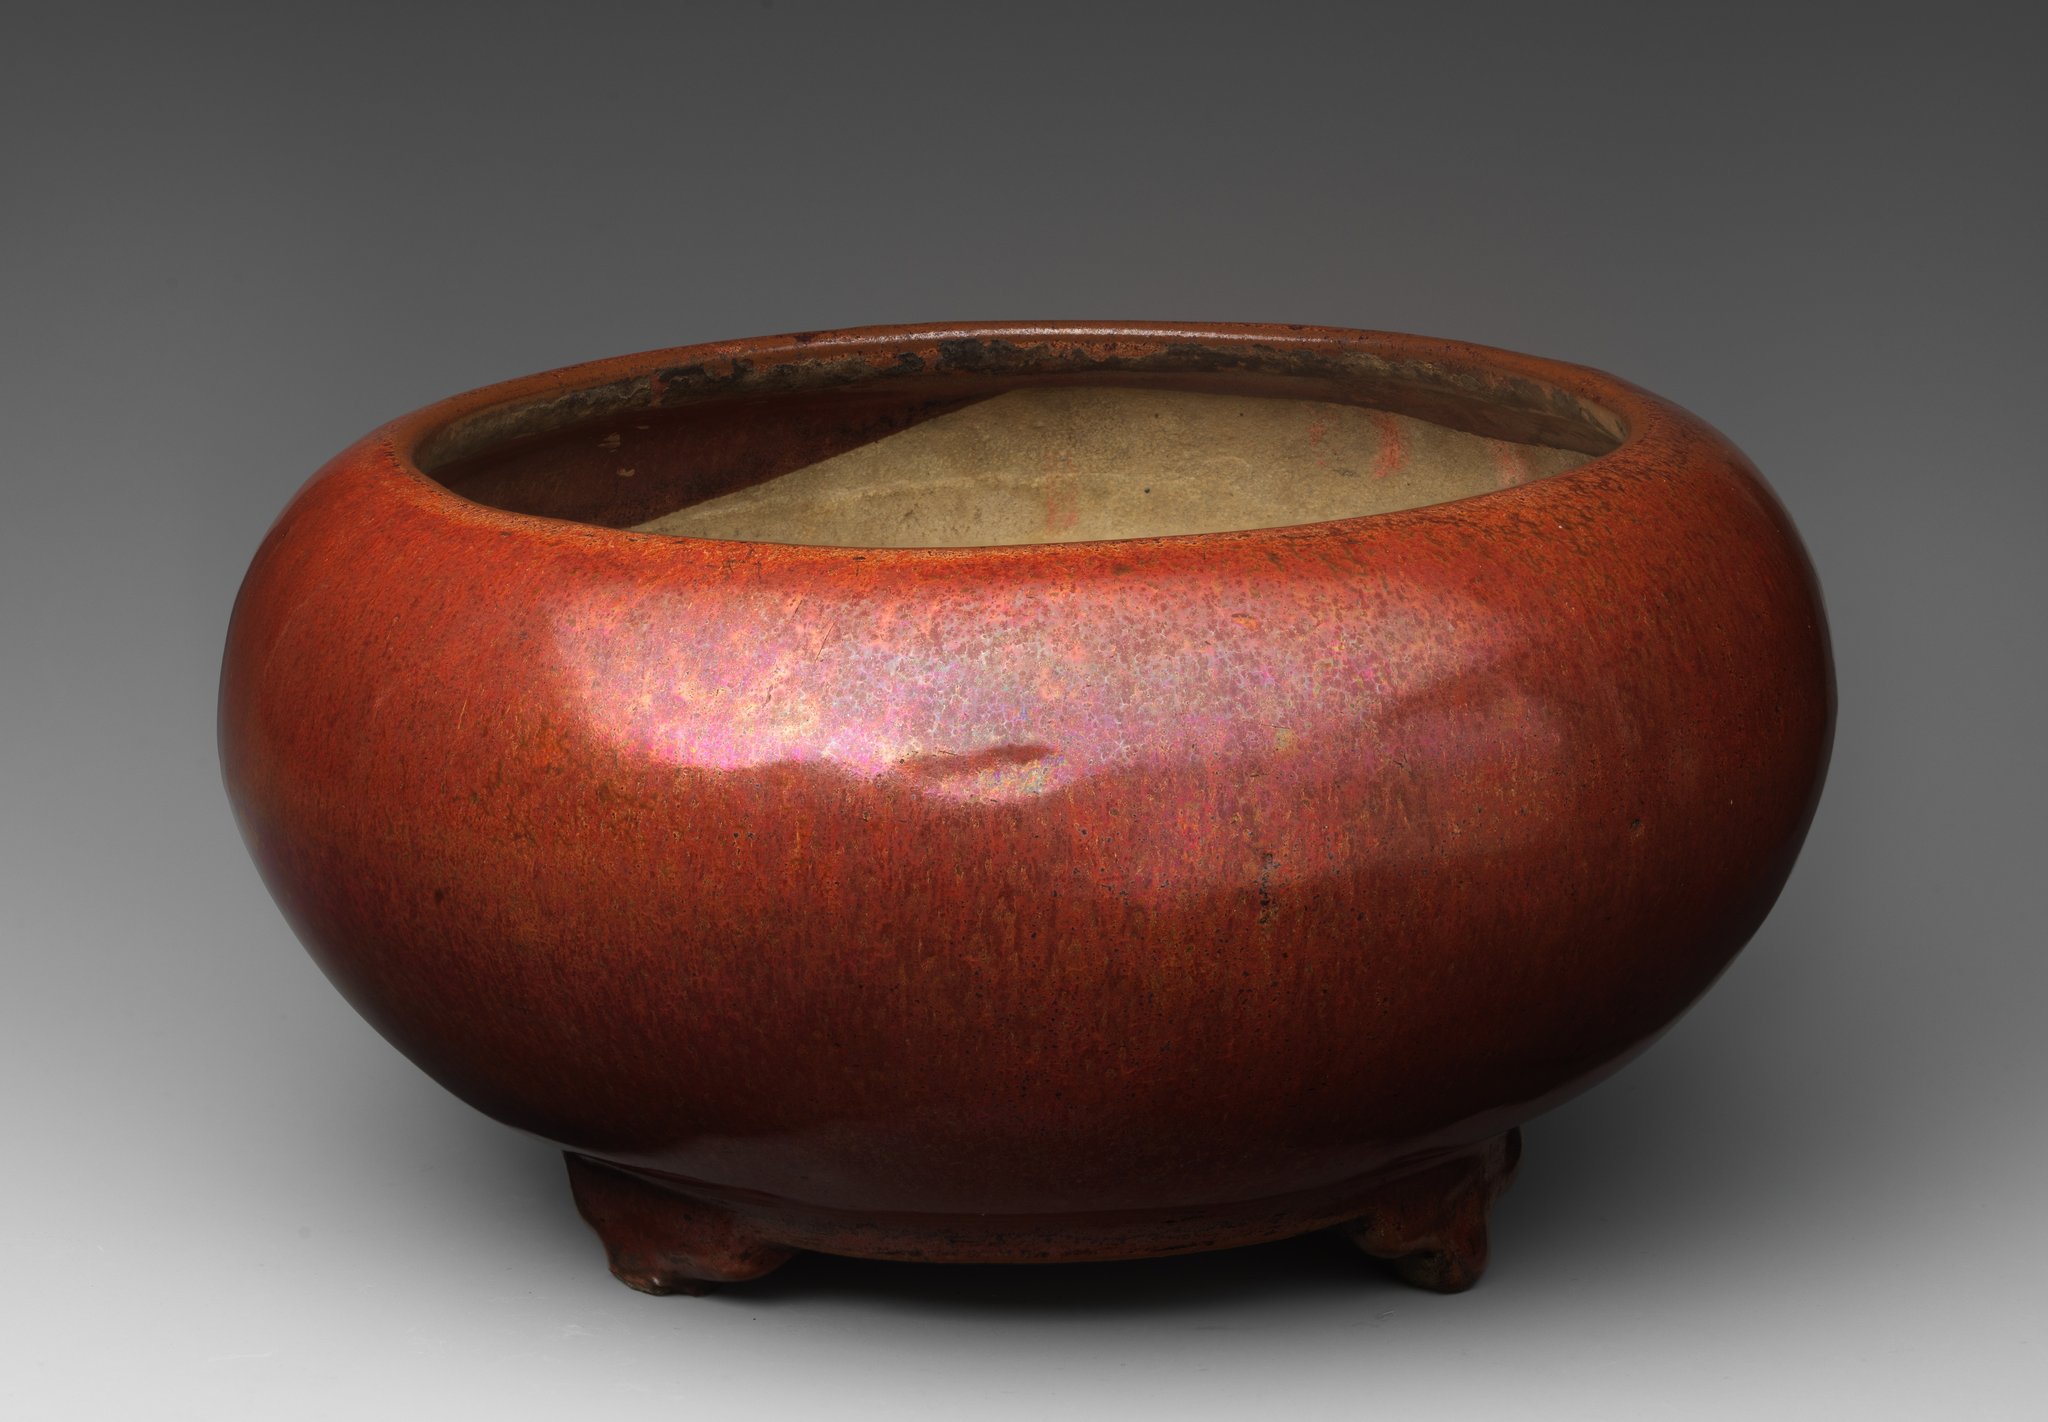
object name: jardinière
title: Jardiniere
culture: japanese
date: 1701-1800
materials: glaze, pottery